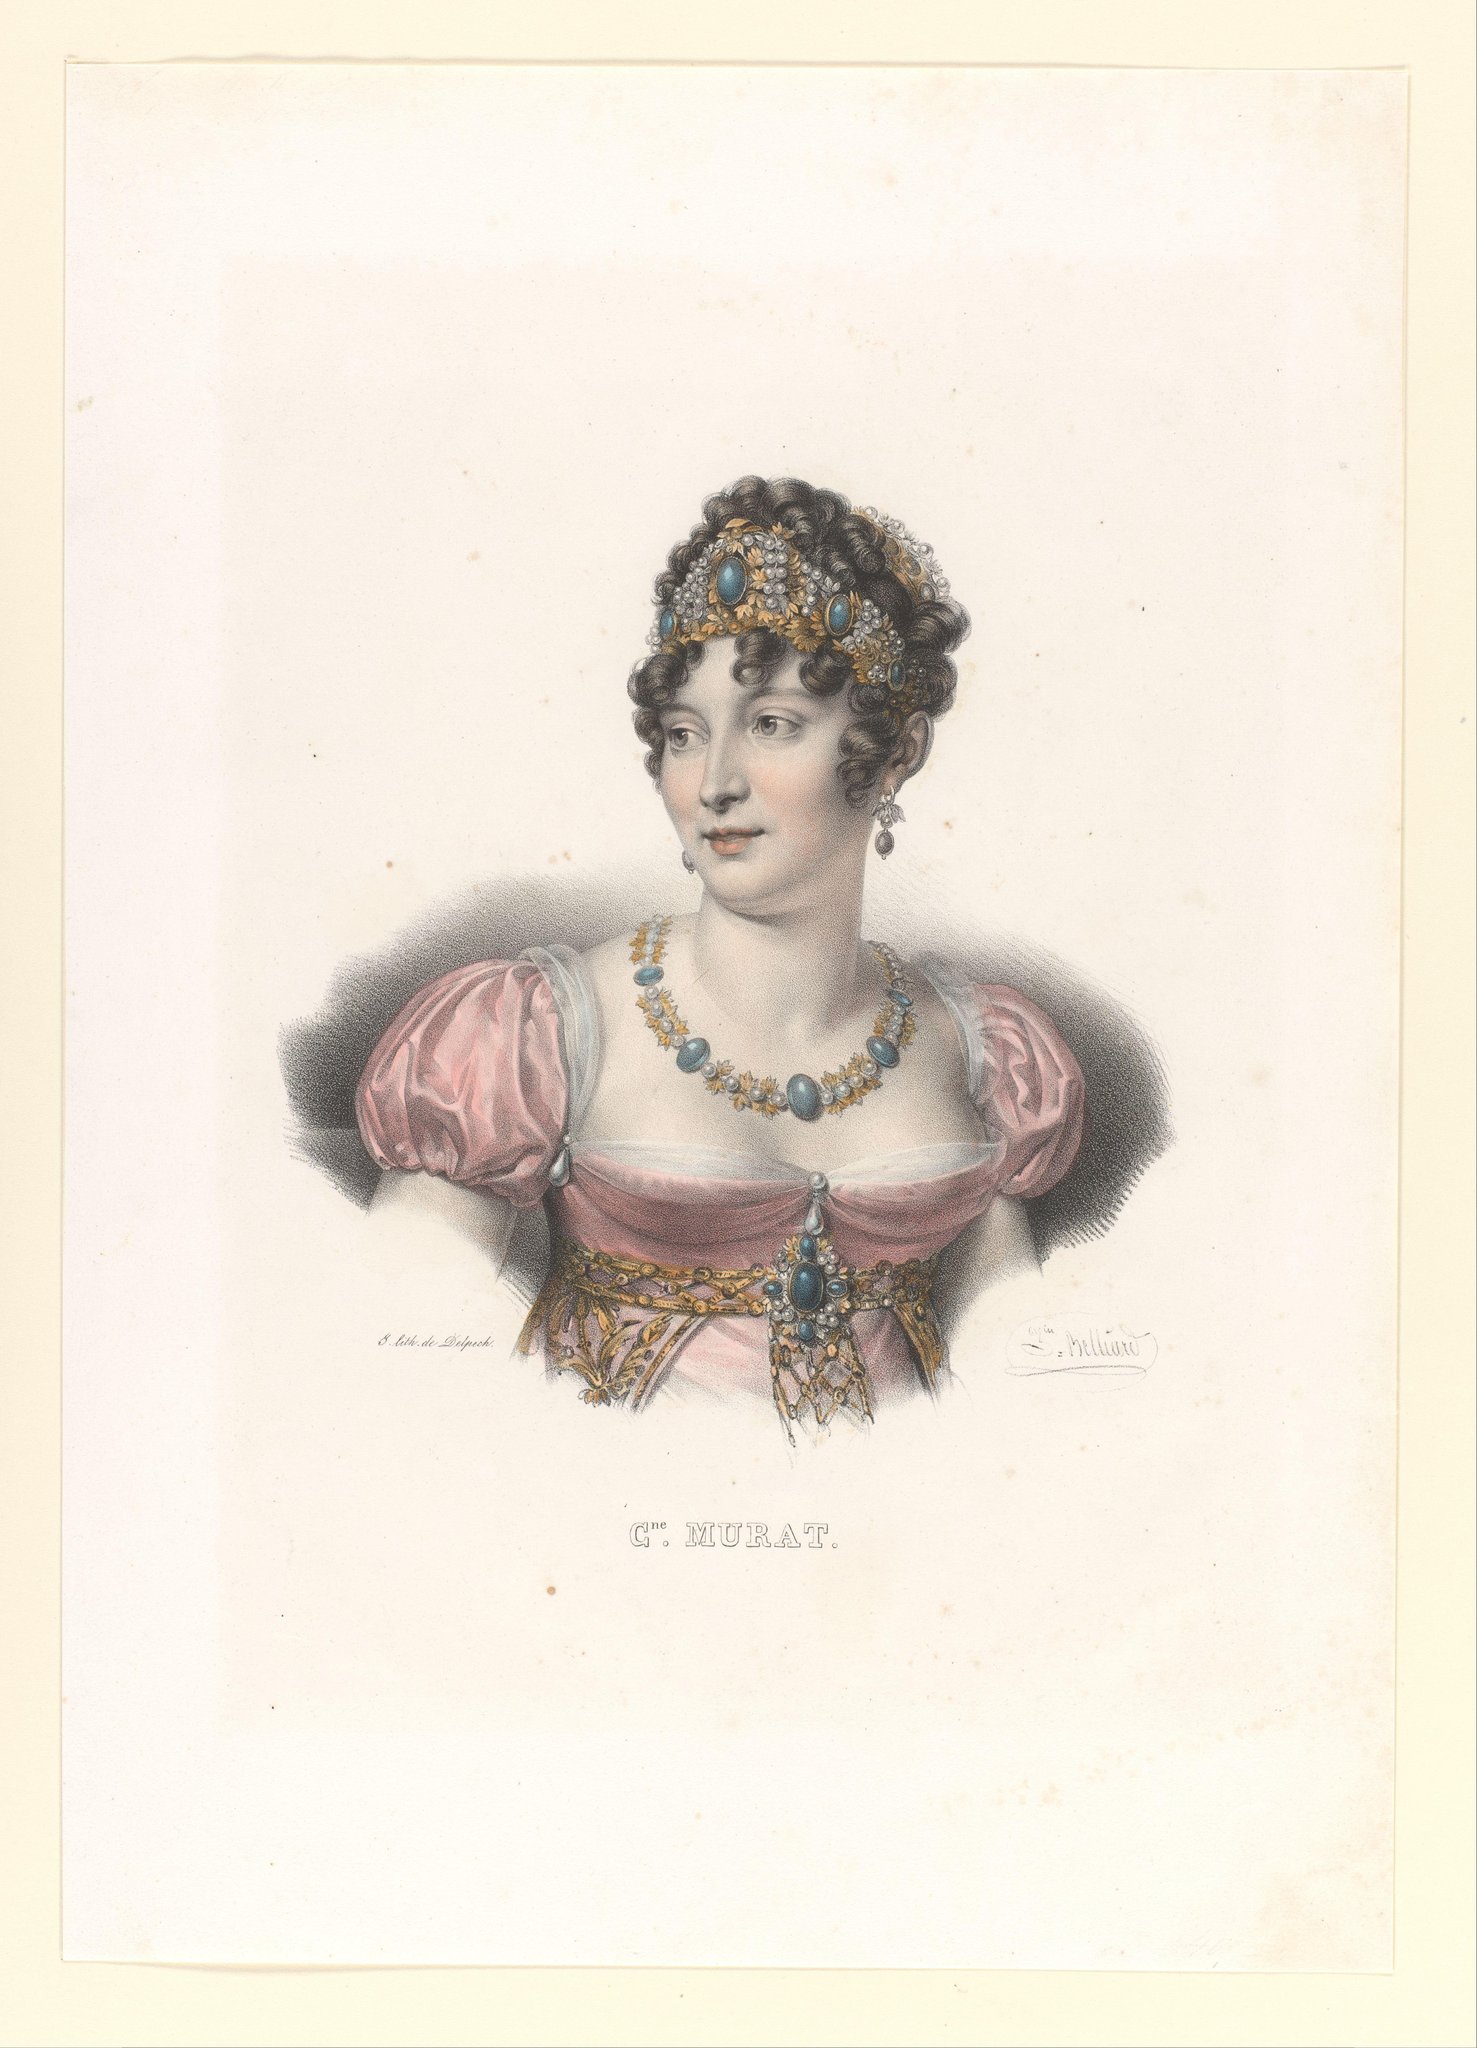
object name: print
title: Cne. Murat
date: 1829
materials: paper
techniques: hand coloring, lithograph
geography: paris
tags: historical persons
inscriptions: collector's mark: Lugt 2228a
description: Prent gepubliceerd in: Iconographie des contemporaines ou portraits des personnes depuis 1789, jusqu'en 1829, Delpech, Parijs 1832.